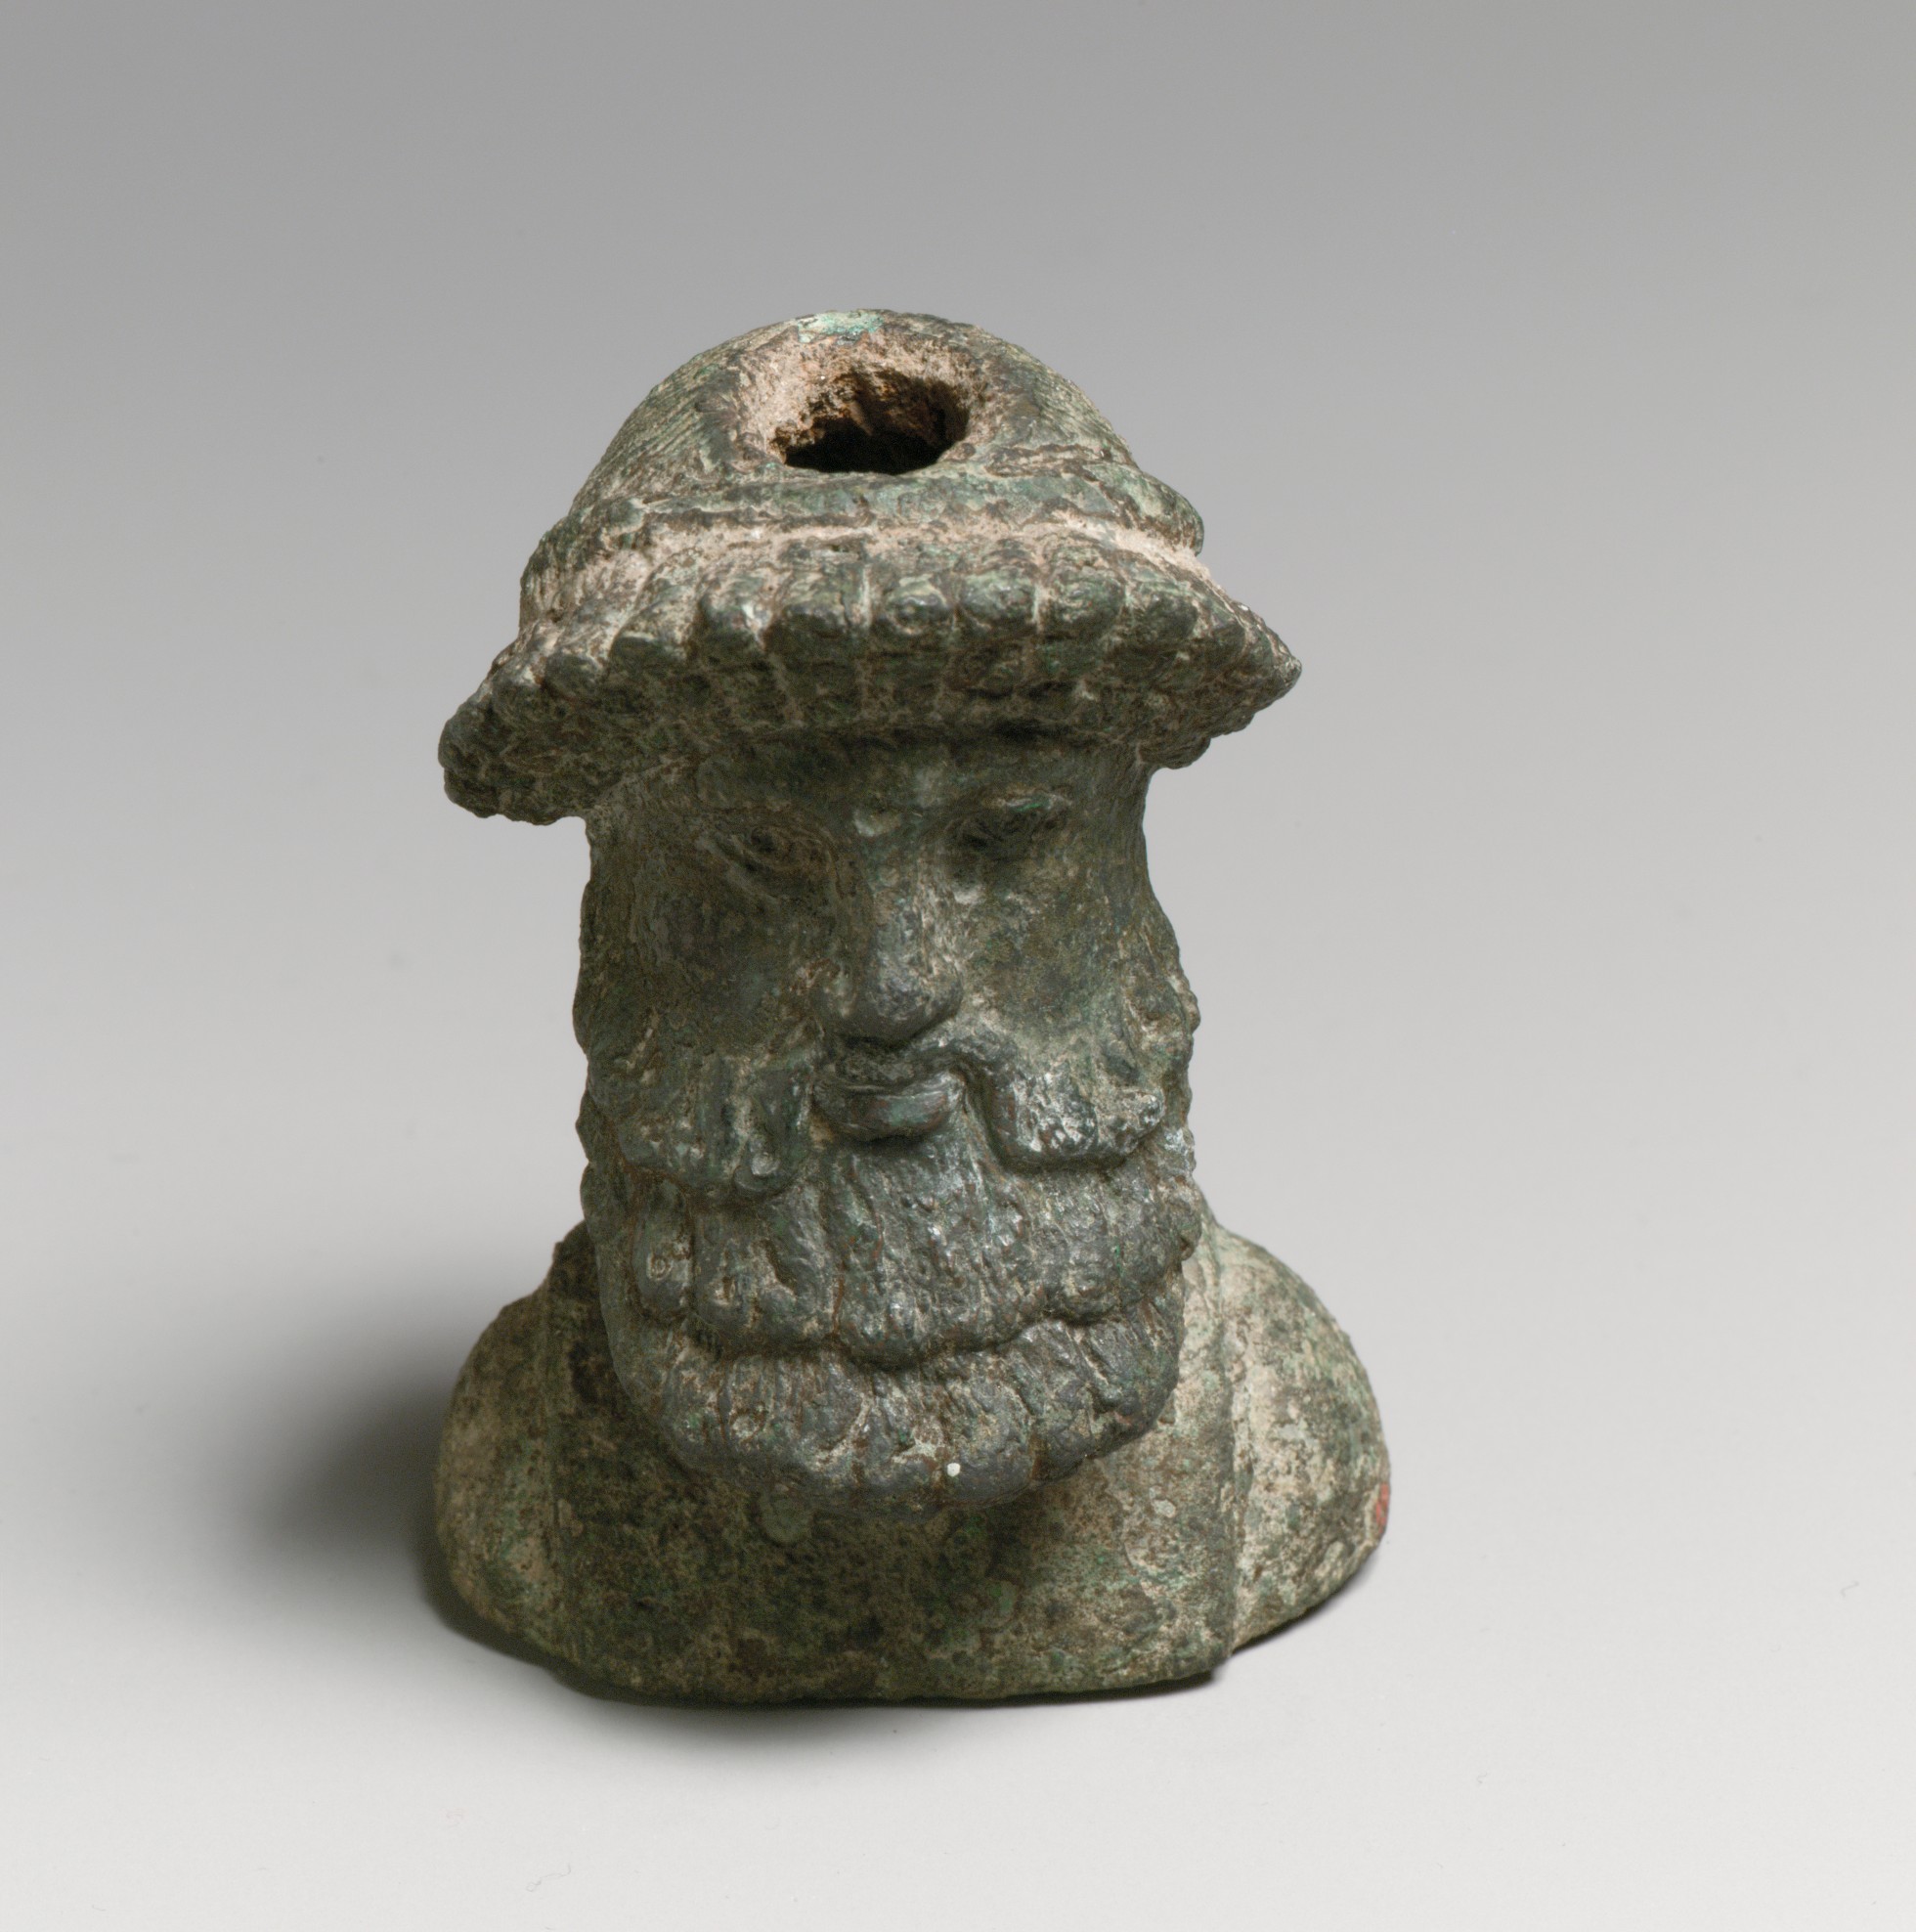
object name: herm of hermes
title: Bronze herm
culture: roman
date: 1-200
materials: bronze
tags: heads,hermes